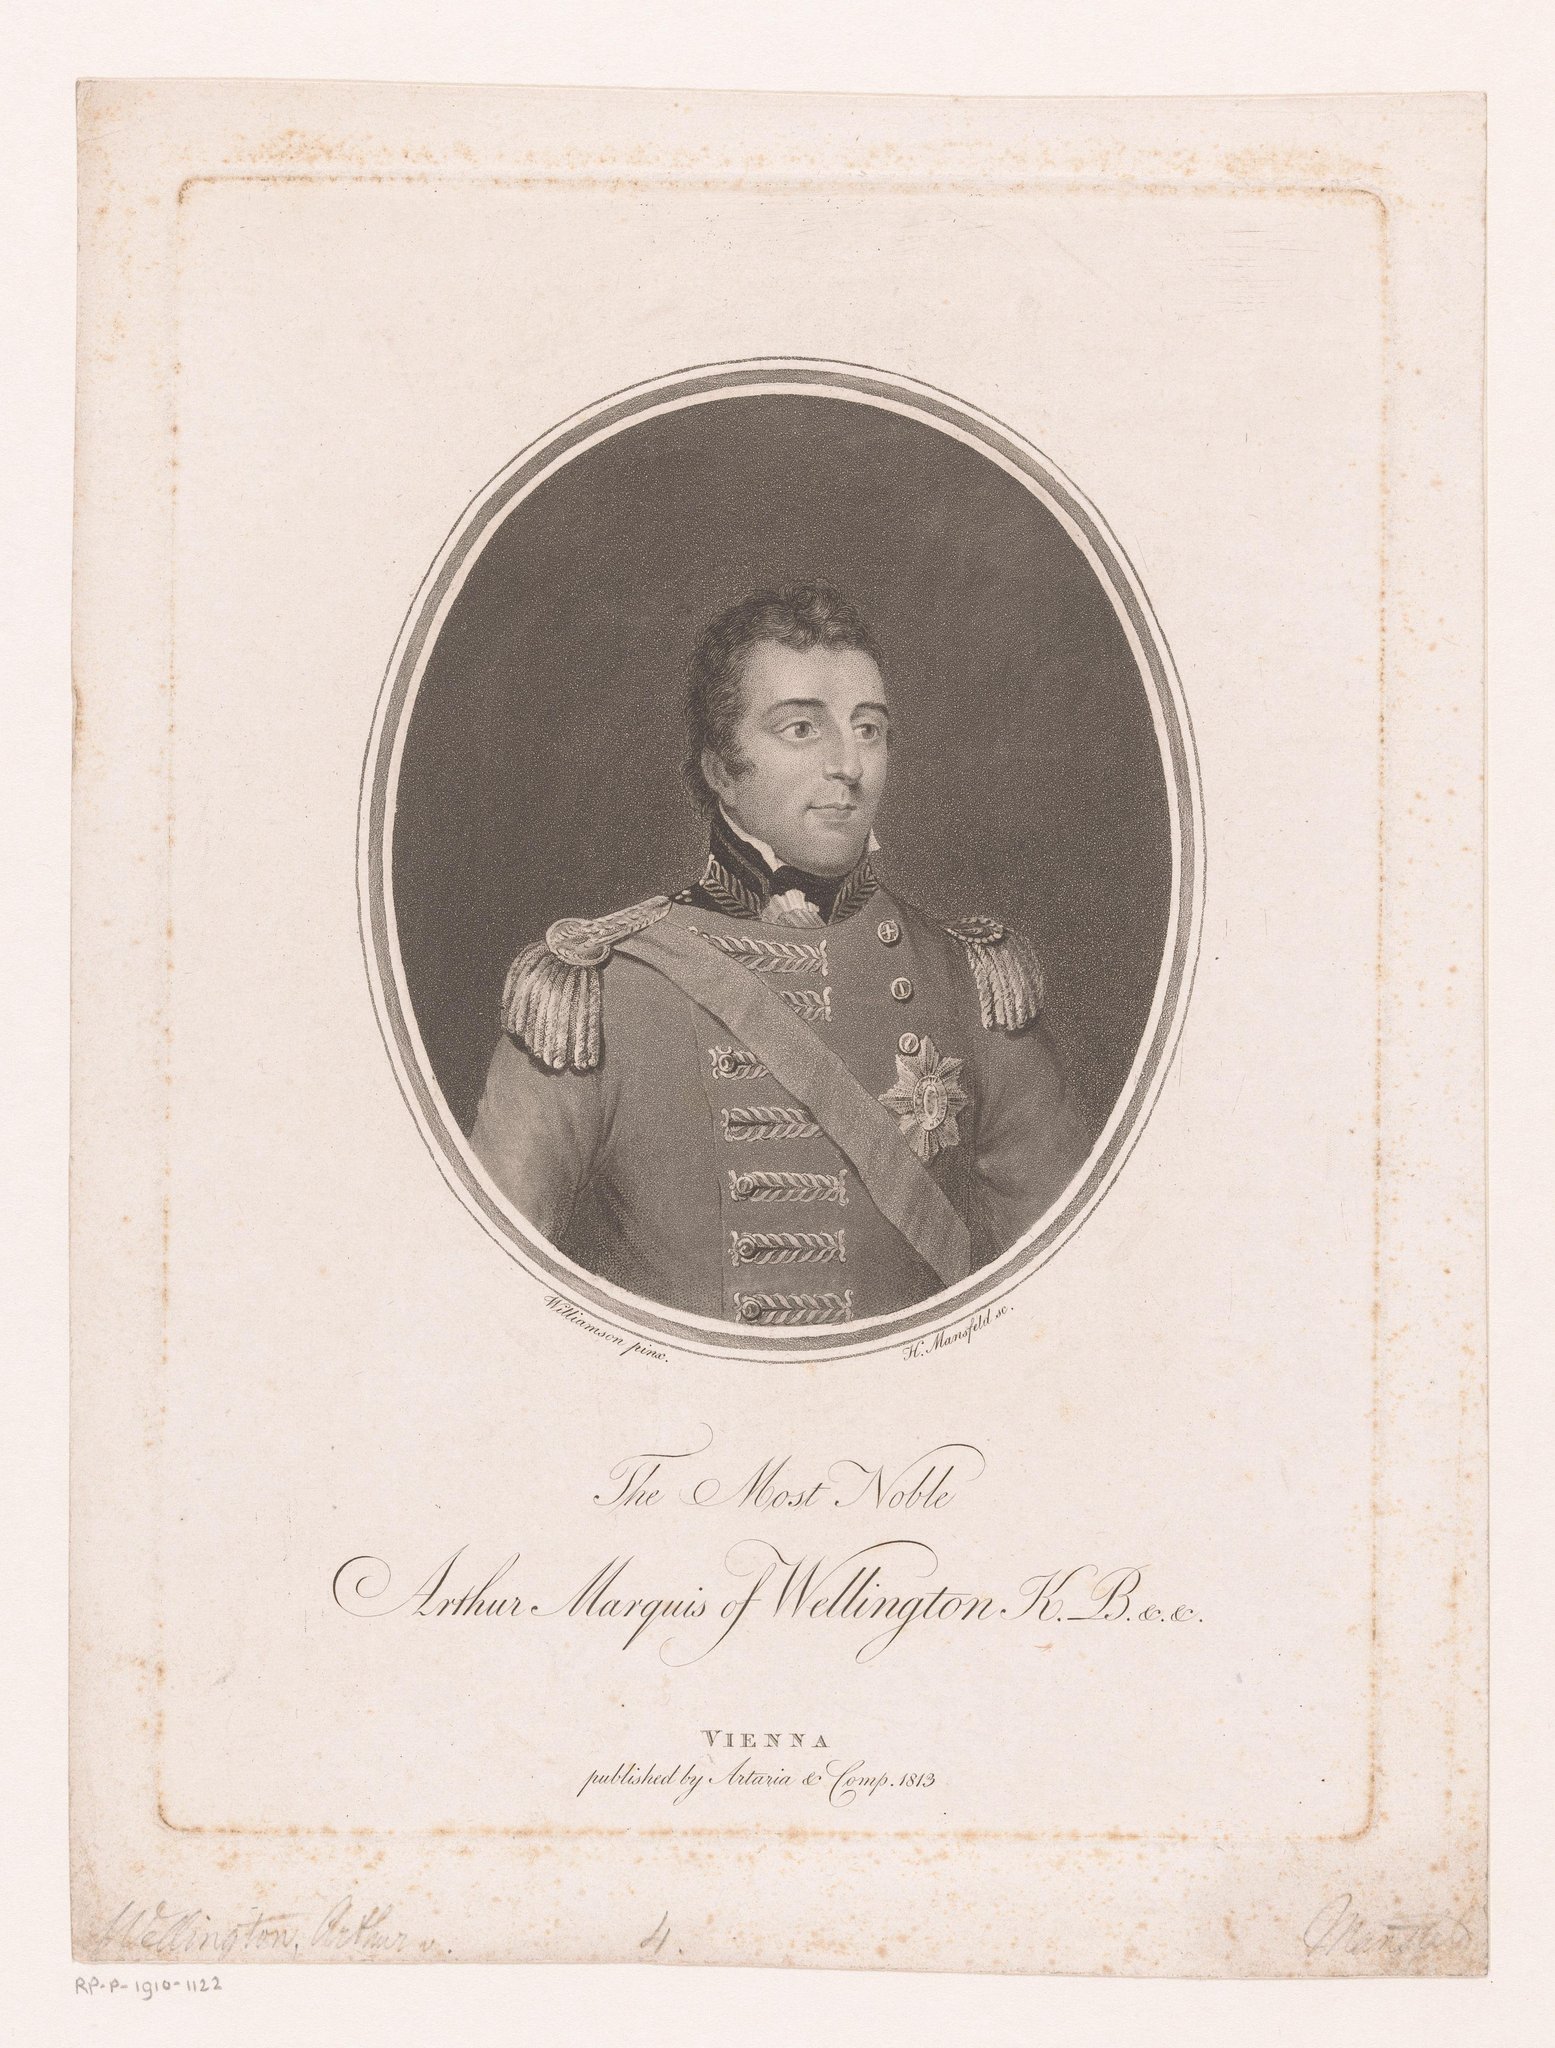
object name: print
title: Portret van Arthur Wellesley, hertog van Wellington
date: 1813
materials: paper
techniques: stippling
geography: vienna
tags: walmer castle, arthur wellesley of wellington, historical persons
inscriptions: collector's mark: Lugt 2228